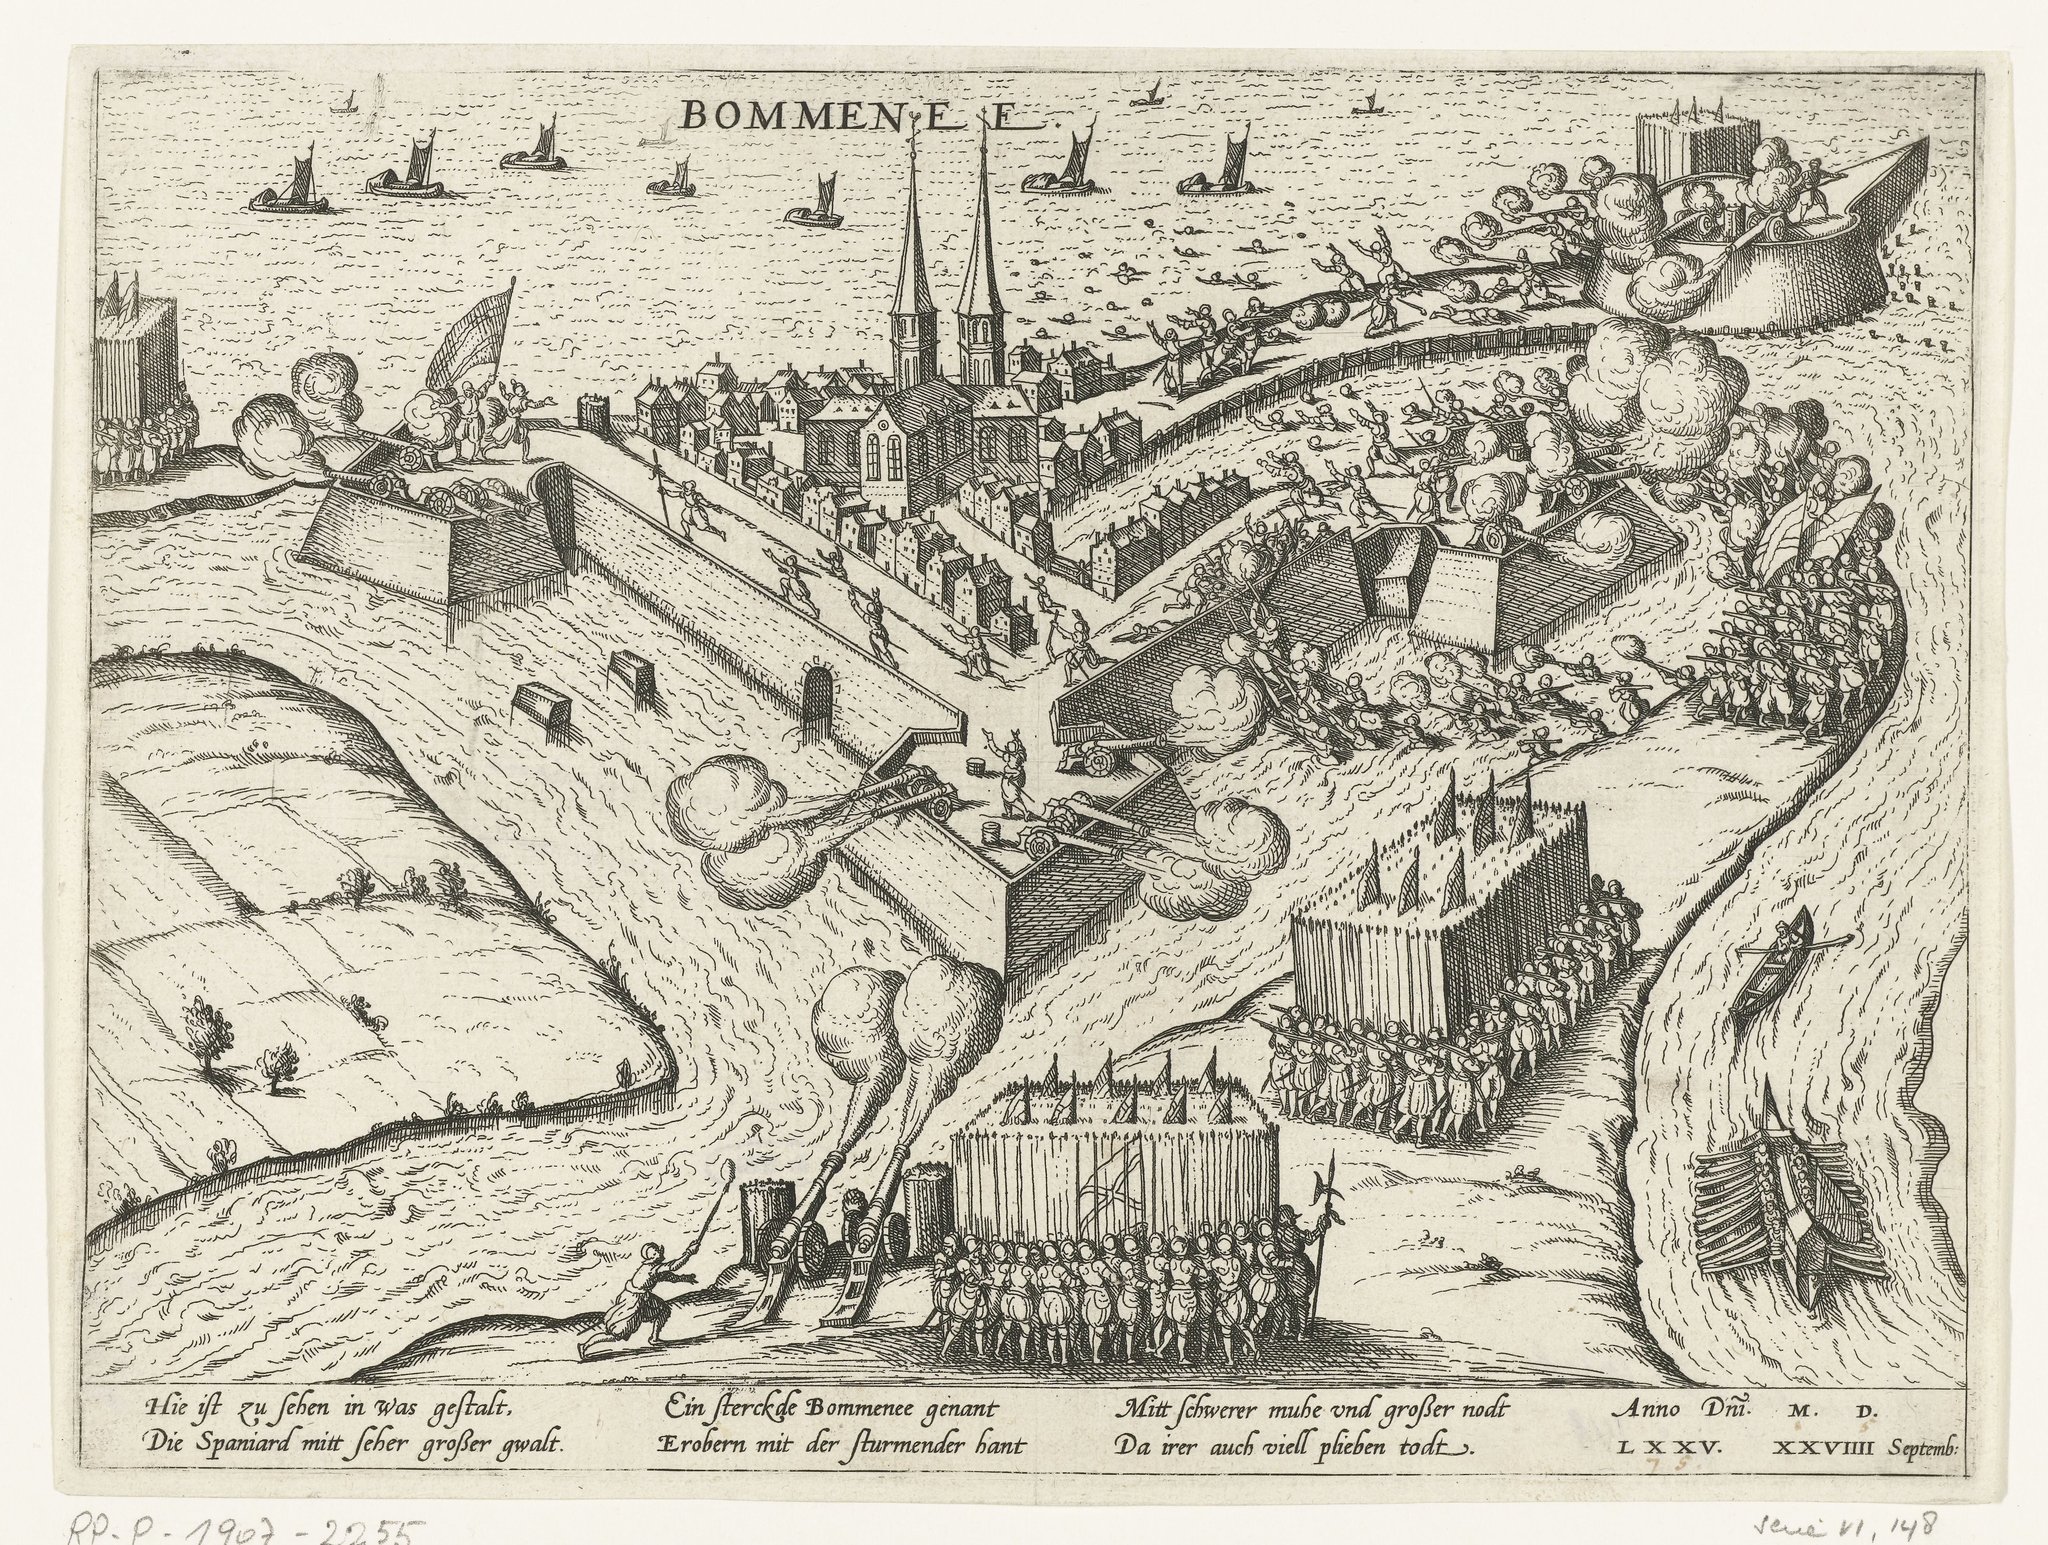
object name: print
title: Bommenede ingenomen door de Spanjaarden, 1575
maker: frans hogenberg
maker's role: print maker, publisher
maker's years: 1538-1590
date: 1575-1577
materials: paper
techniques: etching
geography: cologne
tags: siege, position war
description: Het versterkte stadje Bommenede op het eiland Schouwen in Zeeland belegerd, ingenomen en uitgemoord door de Spanjaarden, 29 september 1575. Met onderschrift van 6 regels in het Duits. Ongenummerd.